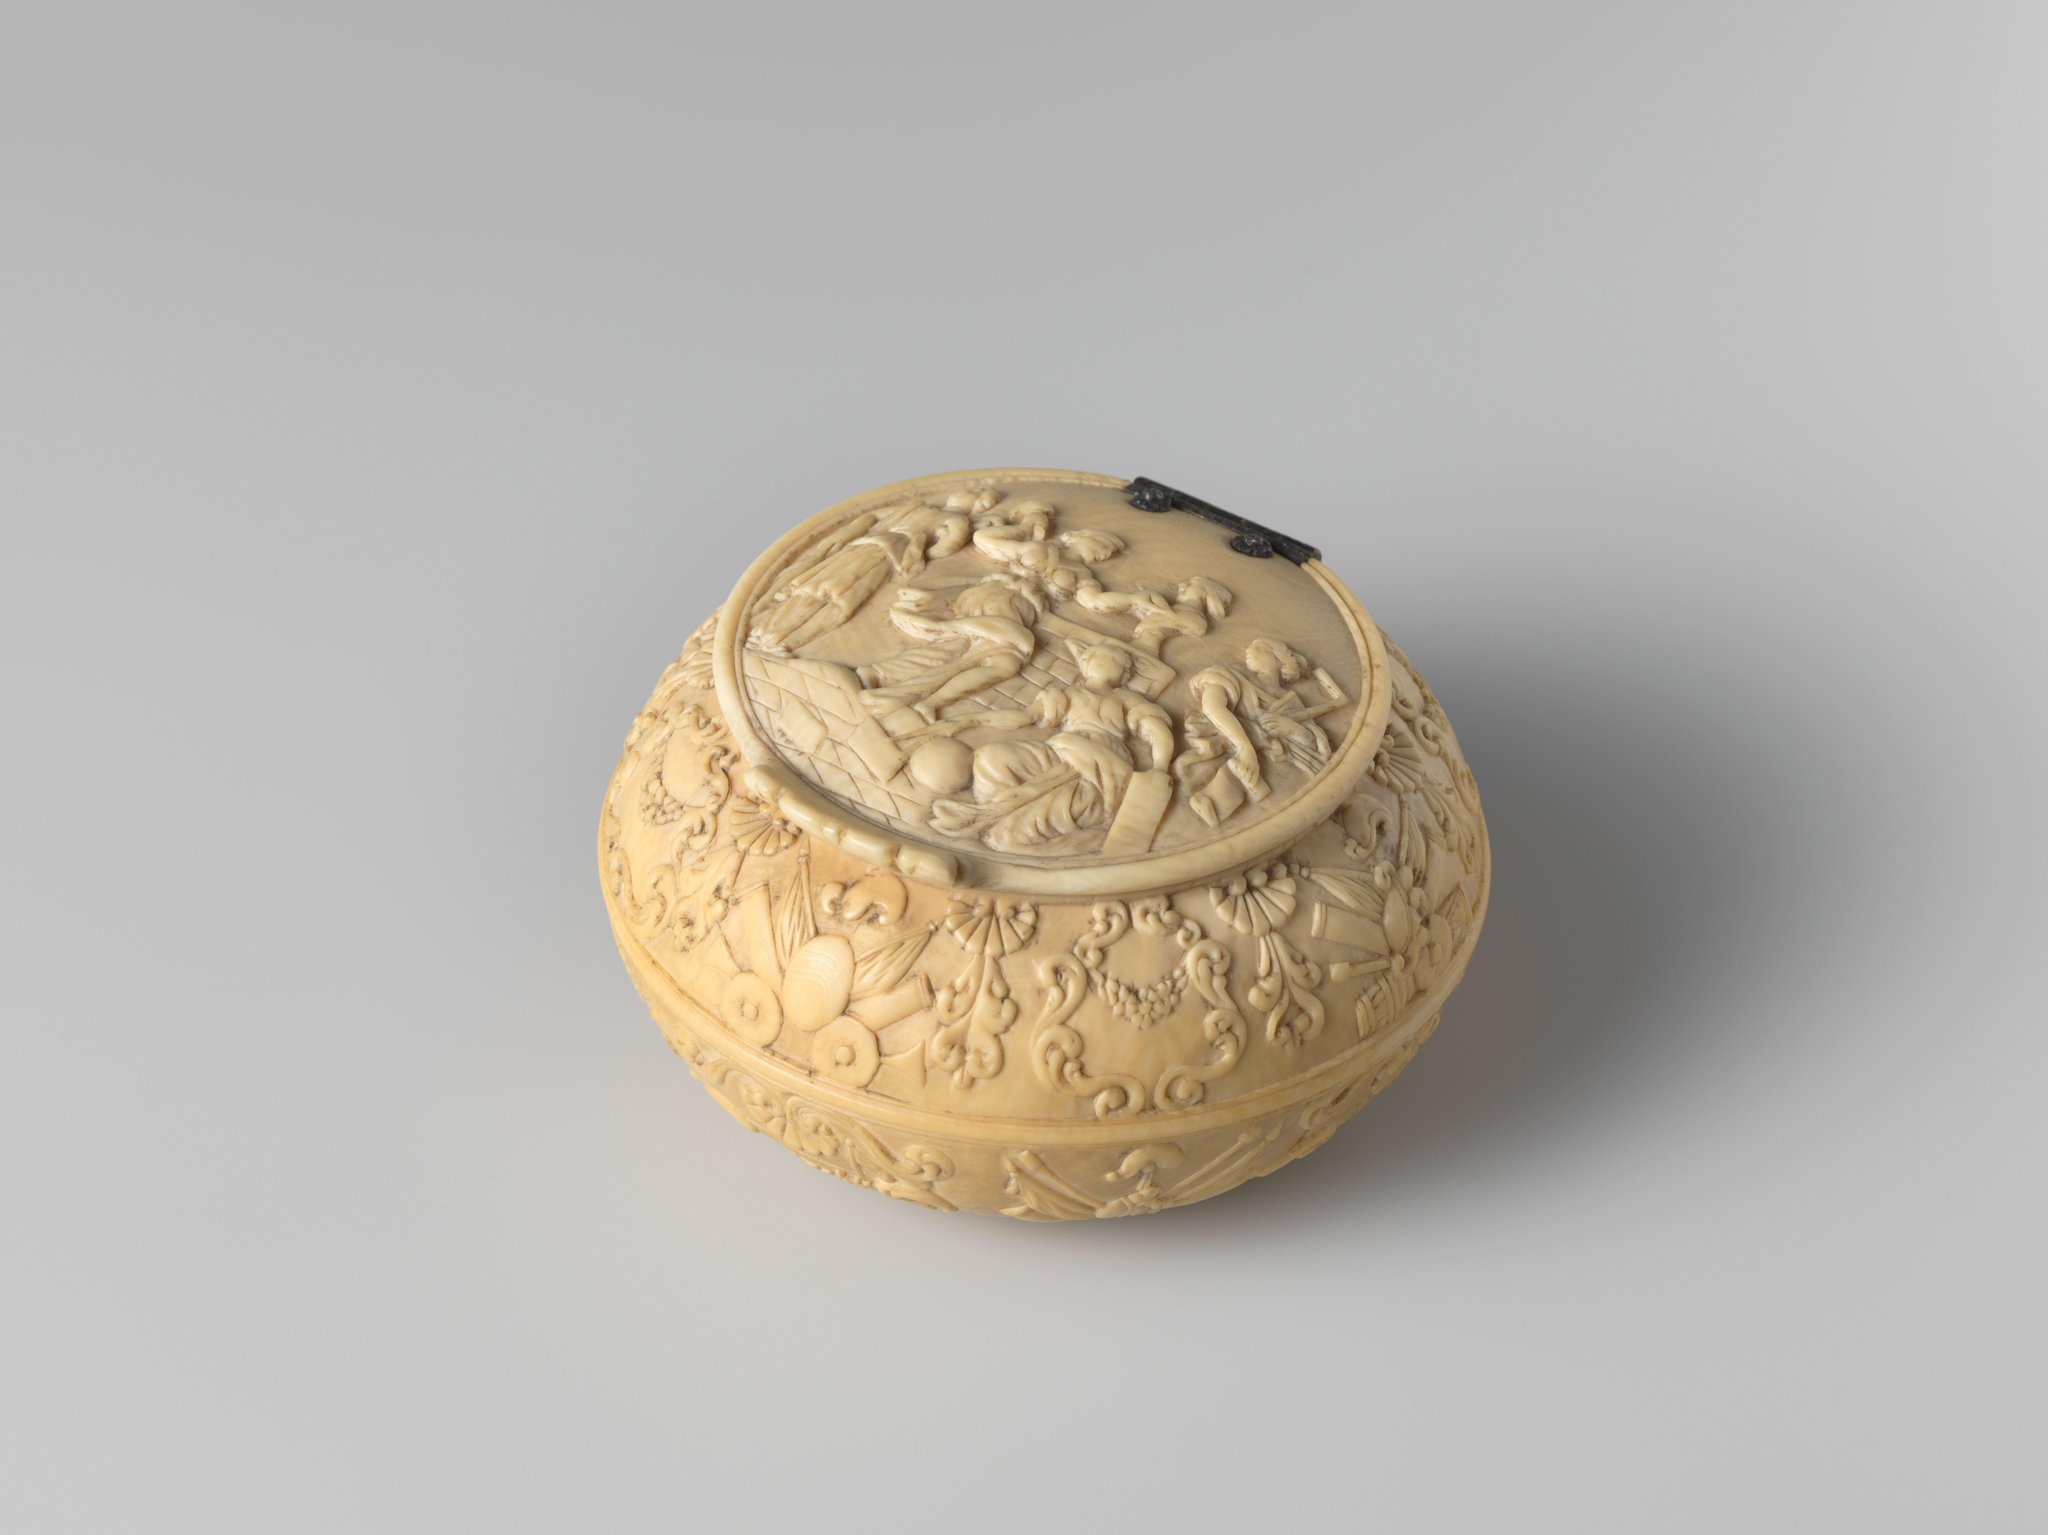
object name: tobacco box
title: Tabaksdoos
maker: Anonymous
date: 1740-1760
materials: ivory, silver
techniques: gilding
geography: dieppe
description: Ronde doos met afgeplatte bolvorm, en rond deksel met verguld zilveren scharnier. De buitenzijde is horizontaal in twee friezen verdeeld, waarop alternerend cartouches en wapentrofeeën met kanonnen, vaandels, harnassen en trommels. De cartouches bevatten in de benedenzone een kleine voorstelling van een zeilschip (onder het scharnier), een landhuis, een ommuurde vesting aan zee, en een landschap met huizen; in de bovenzone zijn de cartouches gevuld met identieke guirlandes. Tussen elke cartouche en trofee is steeds een schelpmotief met een afhangend en een gestileerd afhangend bladmotief geplaatst. De onderzijde draagt een wapenschild met helmteken, voorstellende een klimmende leeuw met erdoorheen een schuine balk waarop drie sterren (familie Nuyts?). Het geheel is geplaatst in een krans van schelpen en guirlandes. Het deksel is versierd met een voorstelling van vier klassieke vrouwen, personificaties van de Vrije kunsten: in het midden Sculptura die een buste hakt, rechtsonder Architectura (een vrouw met passer, bol en rechthoek), rechts staand mogelijk Geometria met winkelhaak, en geheel links een ongeïdentificeerde personificatie met stok en boek. Het scharnier vertoont een fijn gegraveerd patroon van rocaille-achtige motieven die doen denken aan koloniaal zilver.